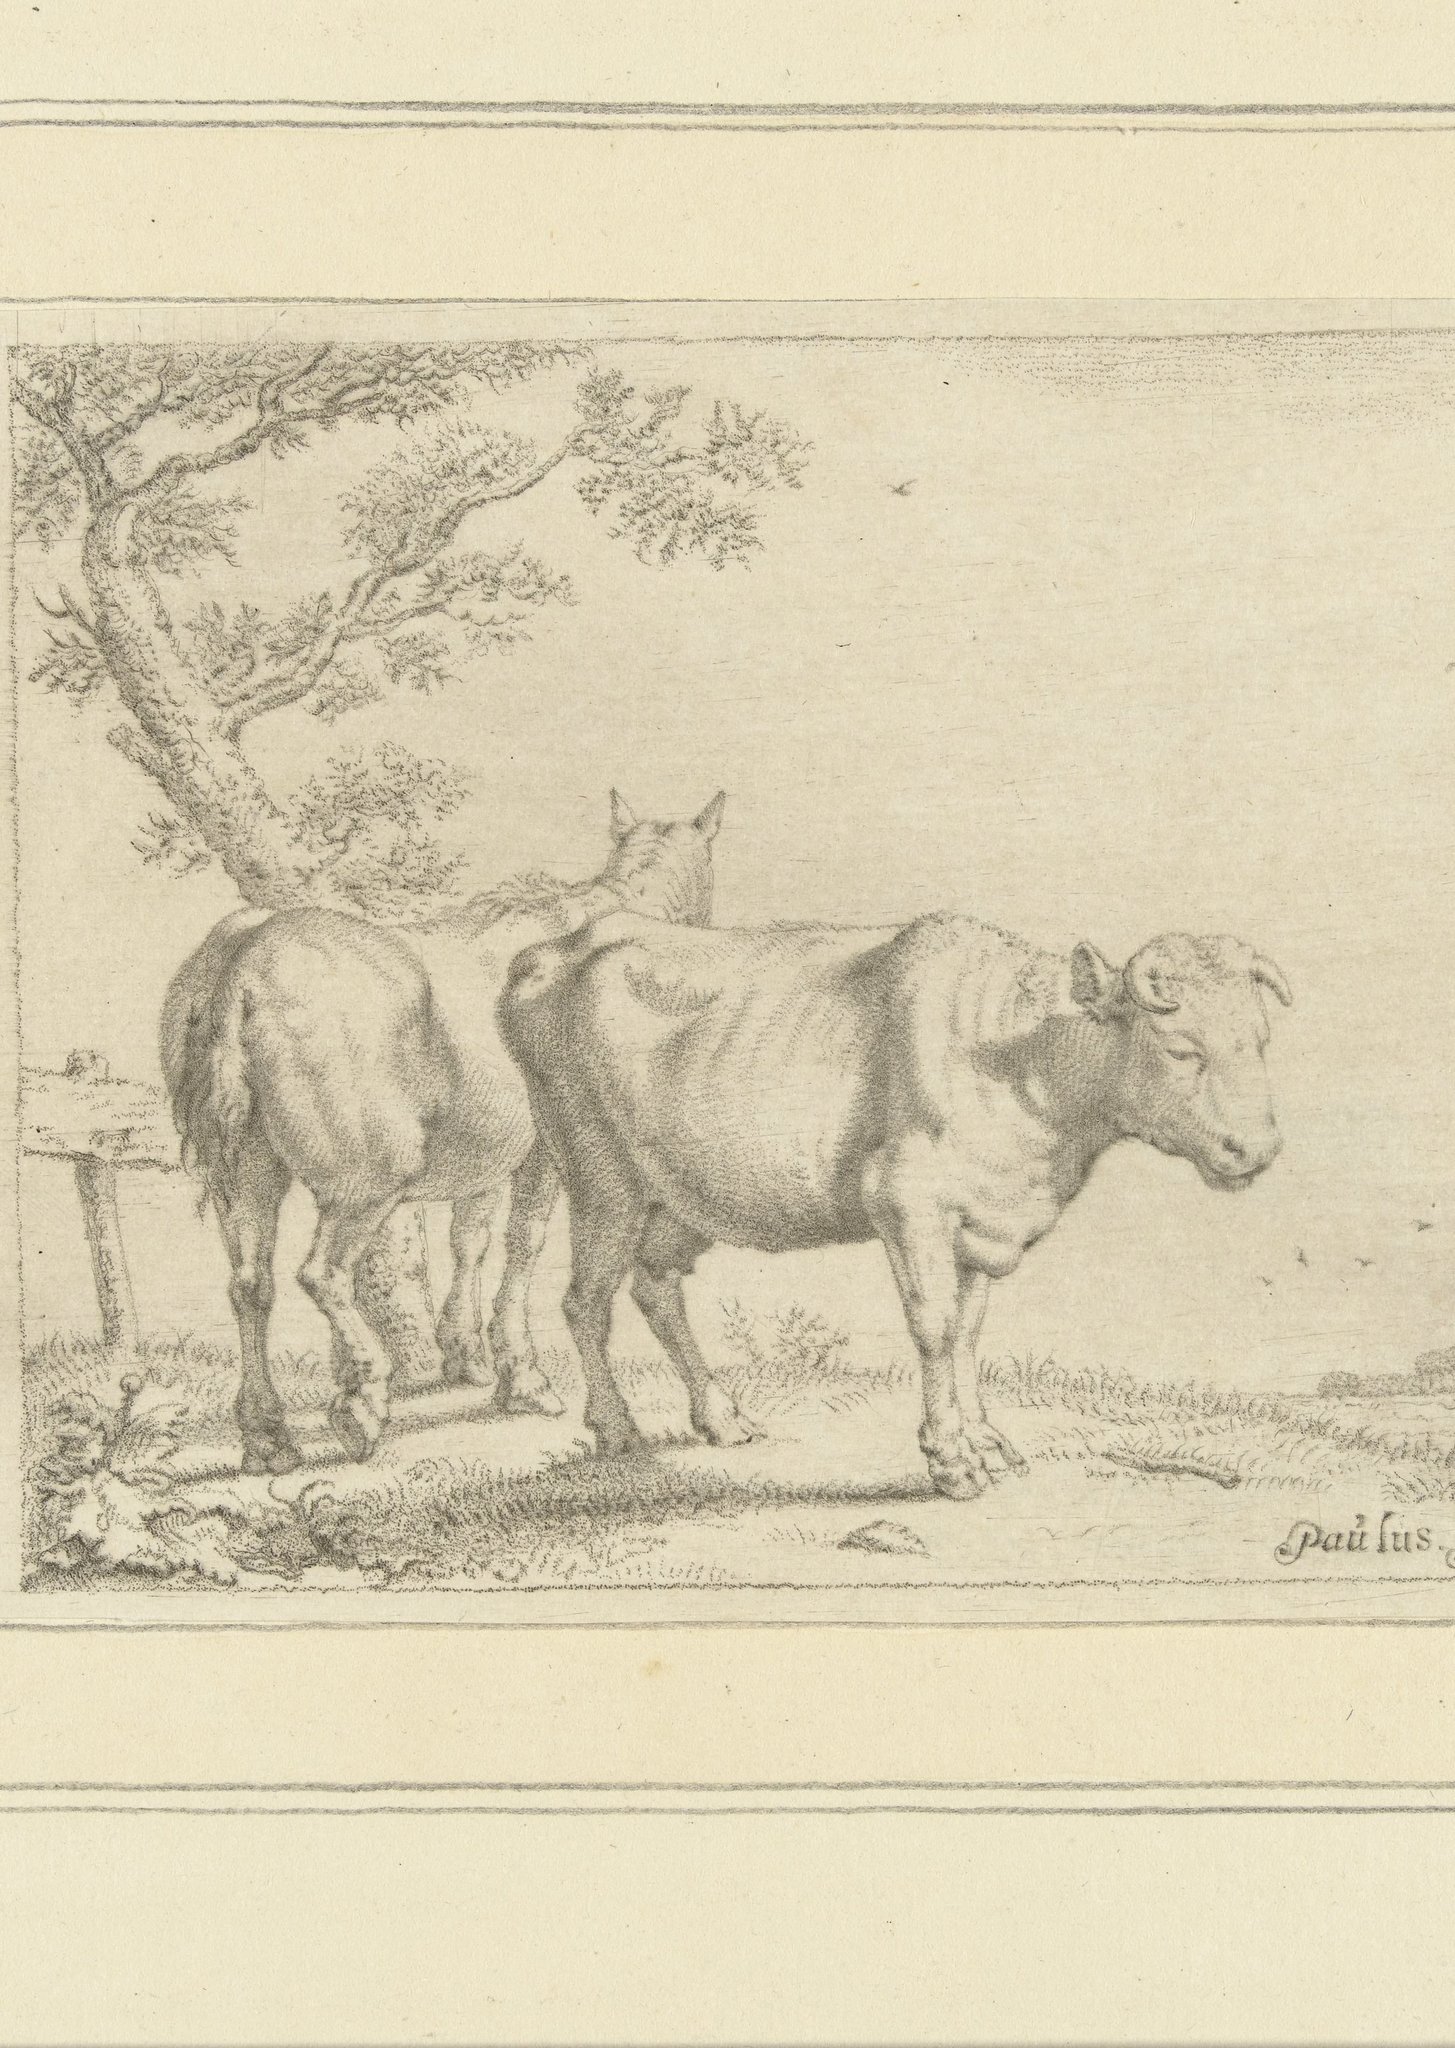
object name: print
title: Landschap met koe en paard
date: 1777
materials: paper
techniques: printmaking, etching, letterpress printing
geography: leiden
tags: cow, horse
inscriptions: collector's mark: Lugt 240, inscription: ‘Door J.J. Bijlaert in `t koper gewerkt. naer Paulus Potter. 1777.’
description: Koe, van voren gezien, en paard, van achter, staand bij boom. De prent is gemonteerd in een dubbel blad waarvan de voorste met de beschrijving van de voorstelling.